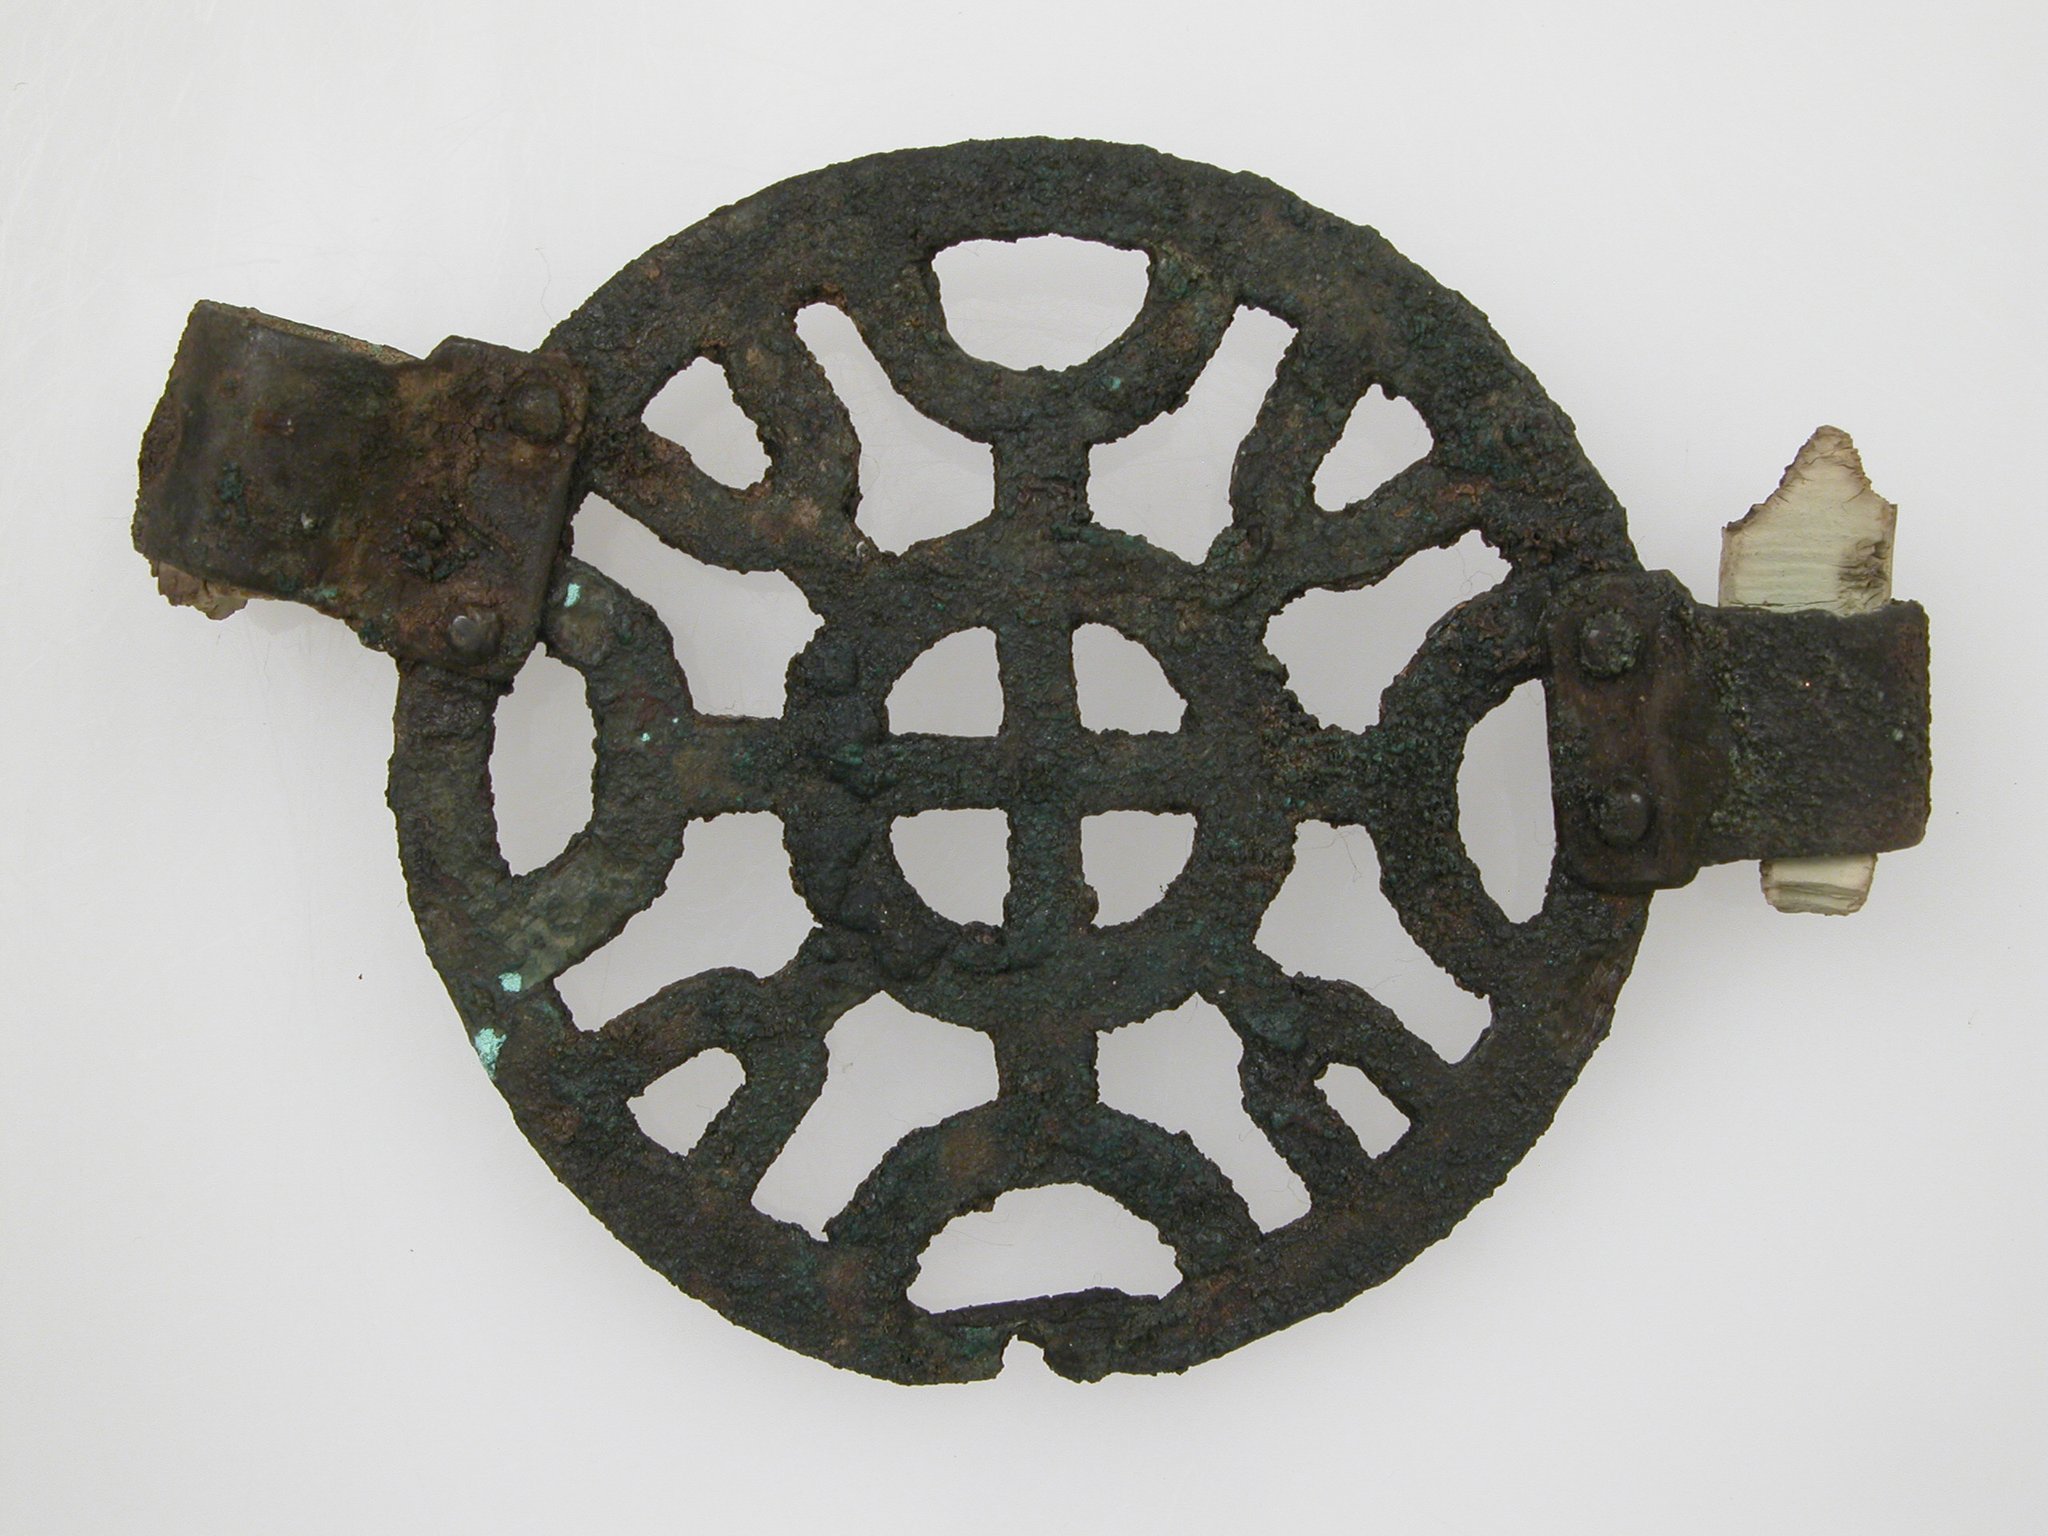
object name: plaque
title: Openwork Belt Mount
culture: frankish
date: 500-700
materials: copper alloy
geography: germany